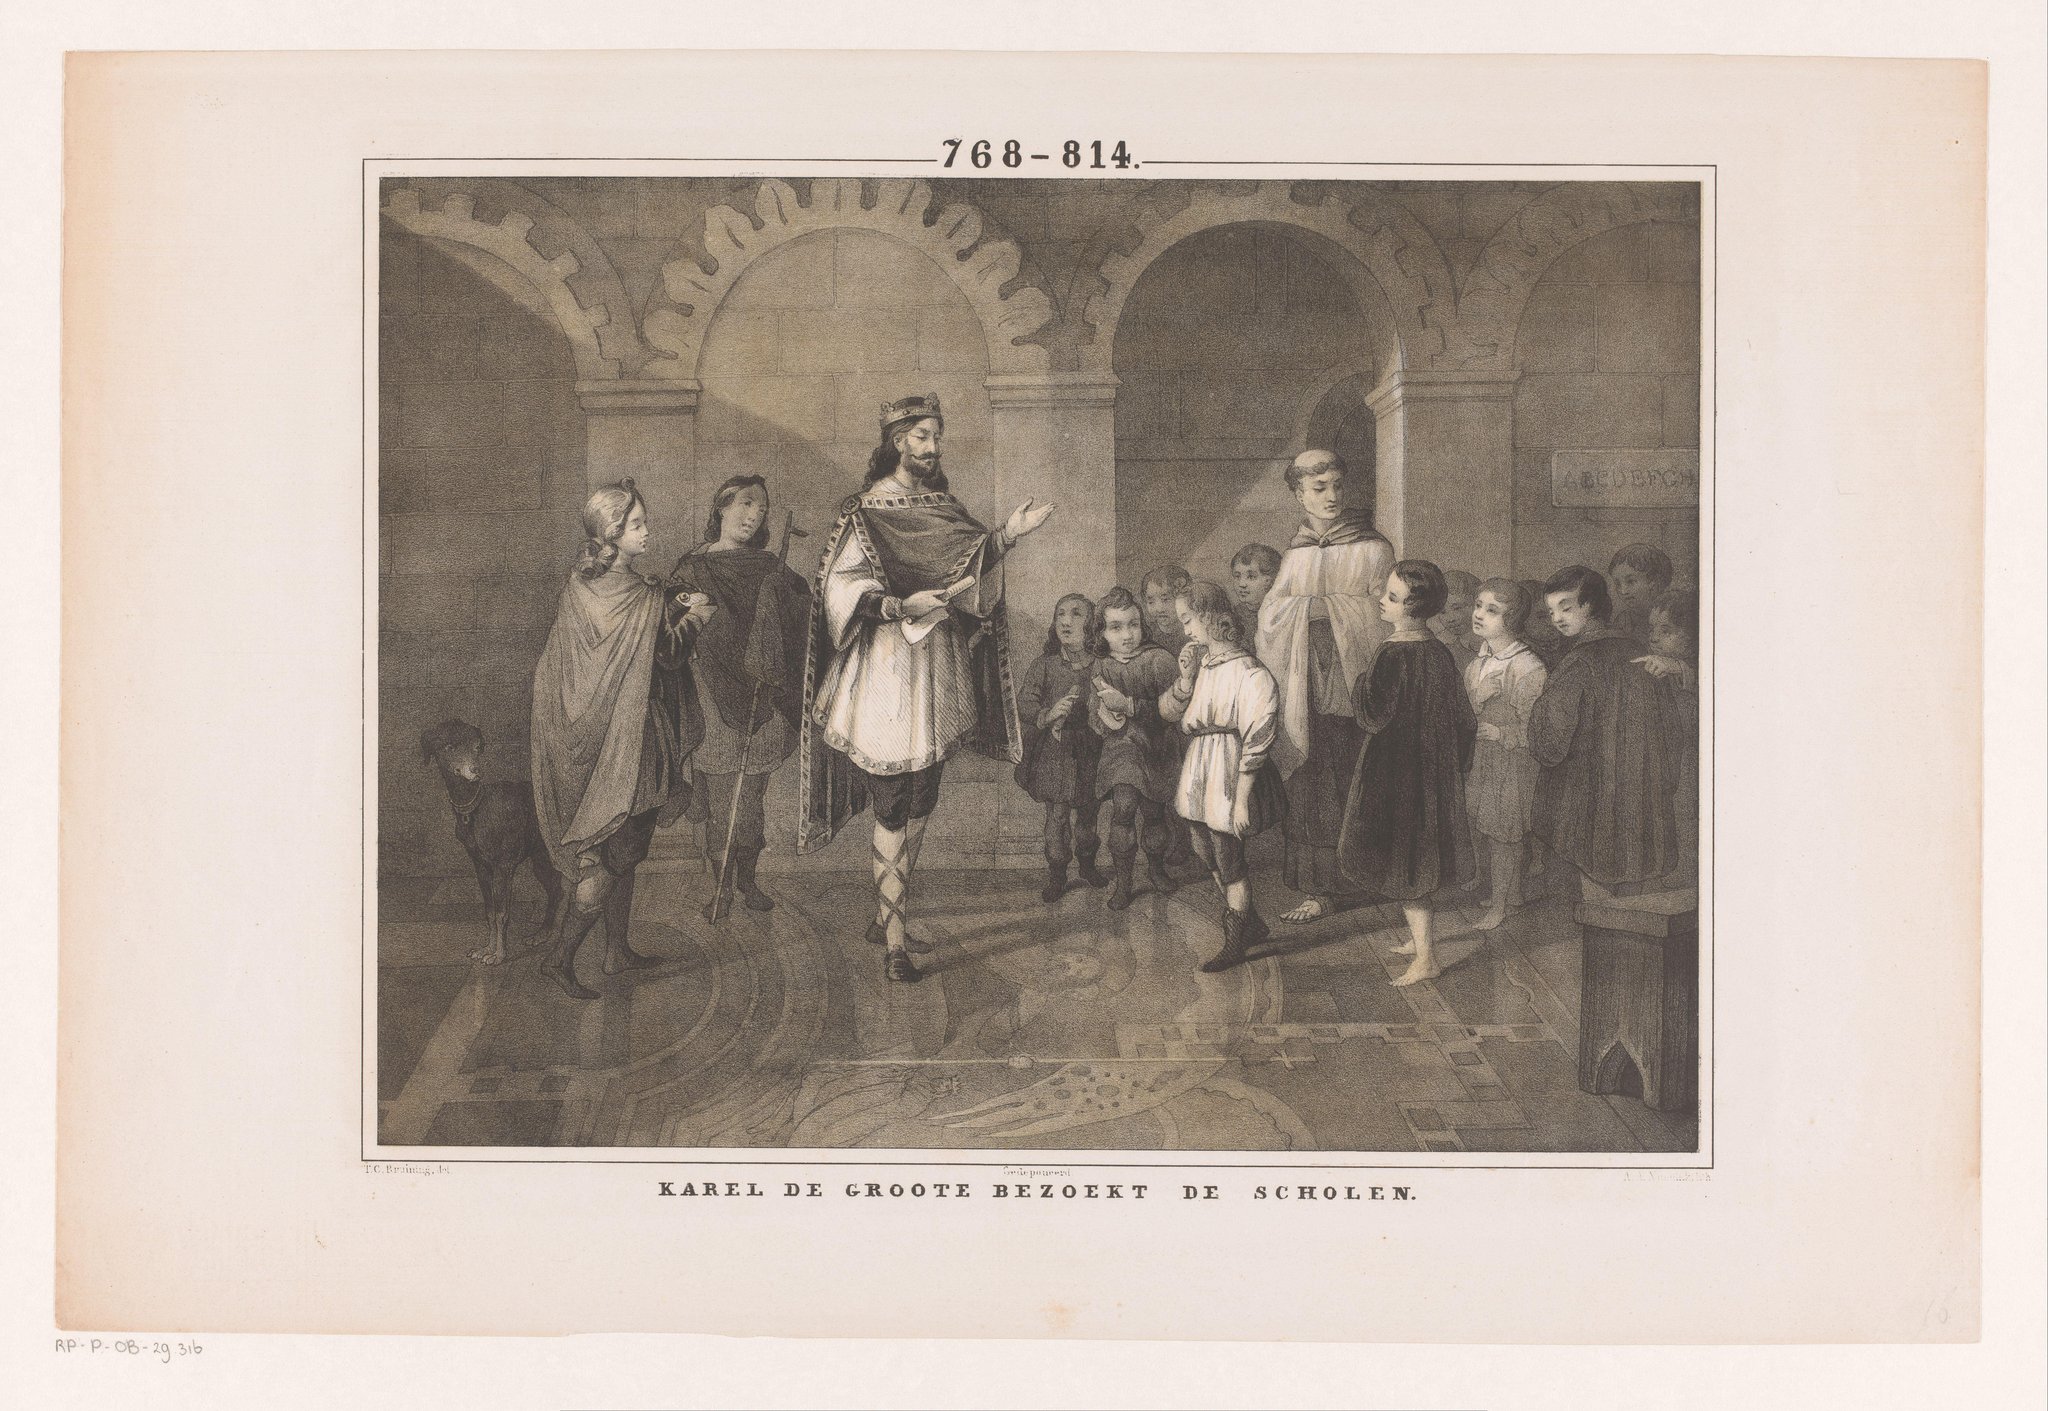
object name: print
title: 768-814 / Karel de Grote bezoekt de scholen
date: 1826-1895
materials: paper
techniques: tone lithography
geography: netherlands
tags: charlemagne (holy roman emperor), elementary school; class, form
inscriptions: : ‘Gedeponeerd.’, collector's mark: Lugt 2228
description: Keizer Karel de Grote bezoekt een school. Bij hem staan een monnik en leerlingen.